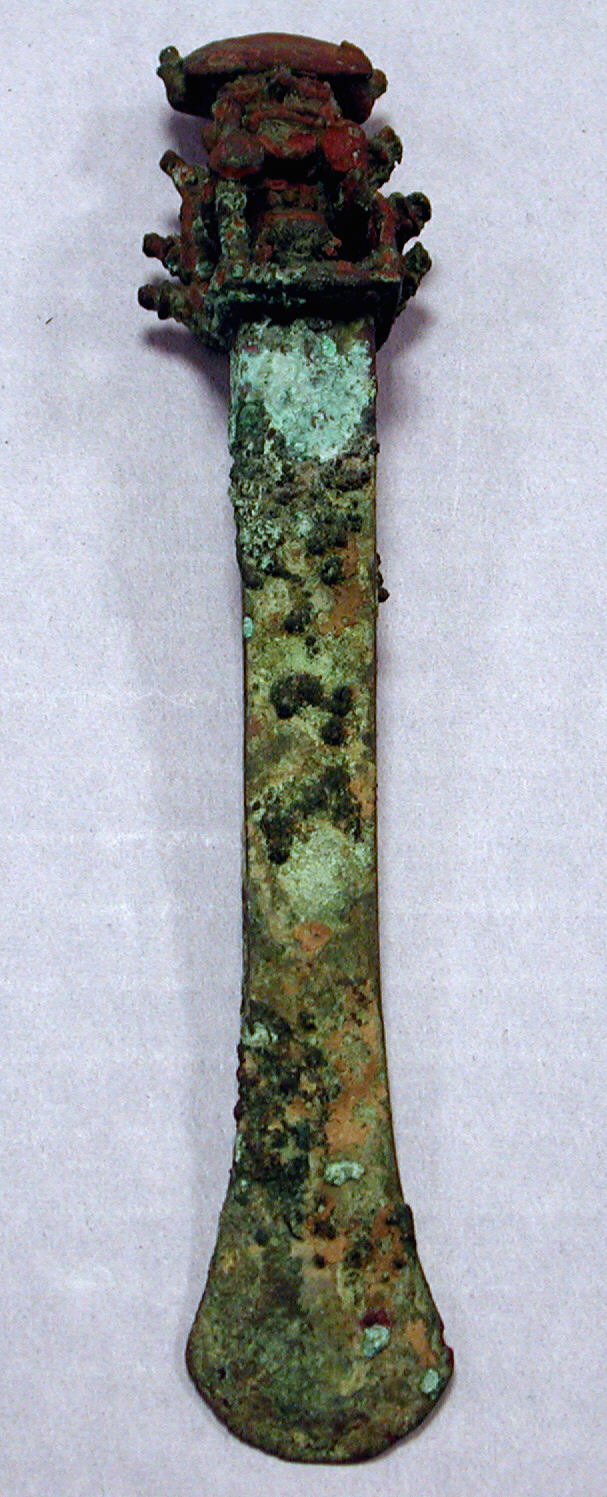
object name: knife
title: Ceremonial Knife (Tumi)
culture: moche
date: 101-700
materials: copper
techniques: casting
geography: peru